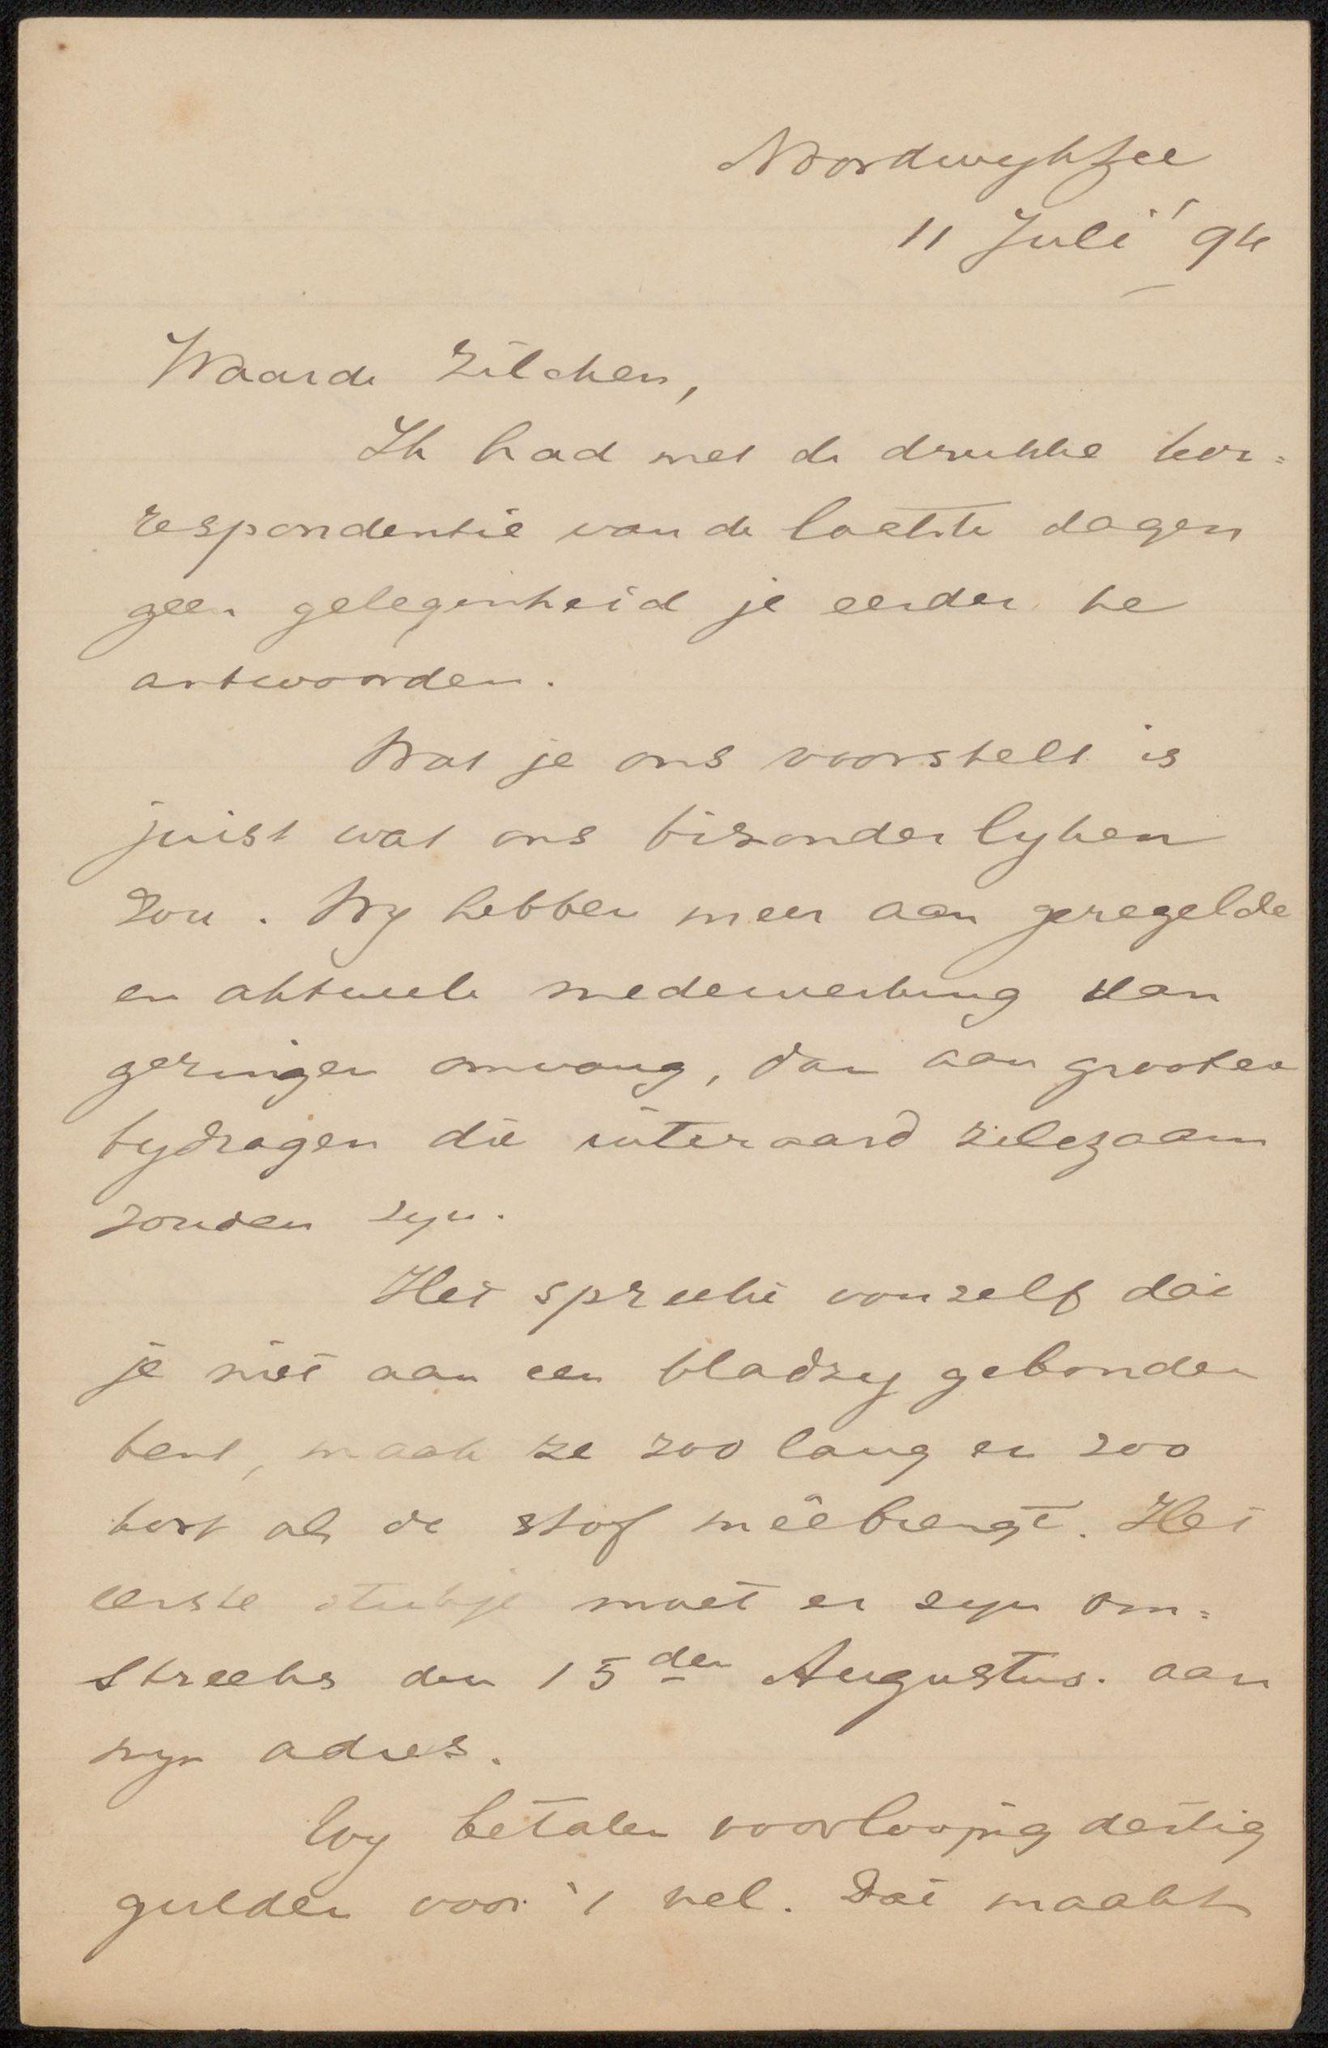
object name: letter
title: Brief aan Philip Zilcken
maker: albert verwey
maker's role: criticus, dichter, essayist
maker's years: 1865-1937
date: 1894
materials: ink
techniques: pen, writing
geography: noordwijk aan zee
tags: cologne, johan thorn prikker, the hague, painter, philip zilcken, money, printed matter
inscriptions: collector's mark: ‘RPK’